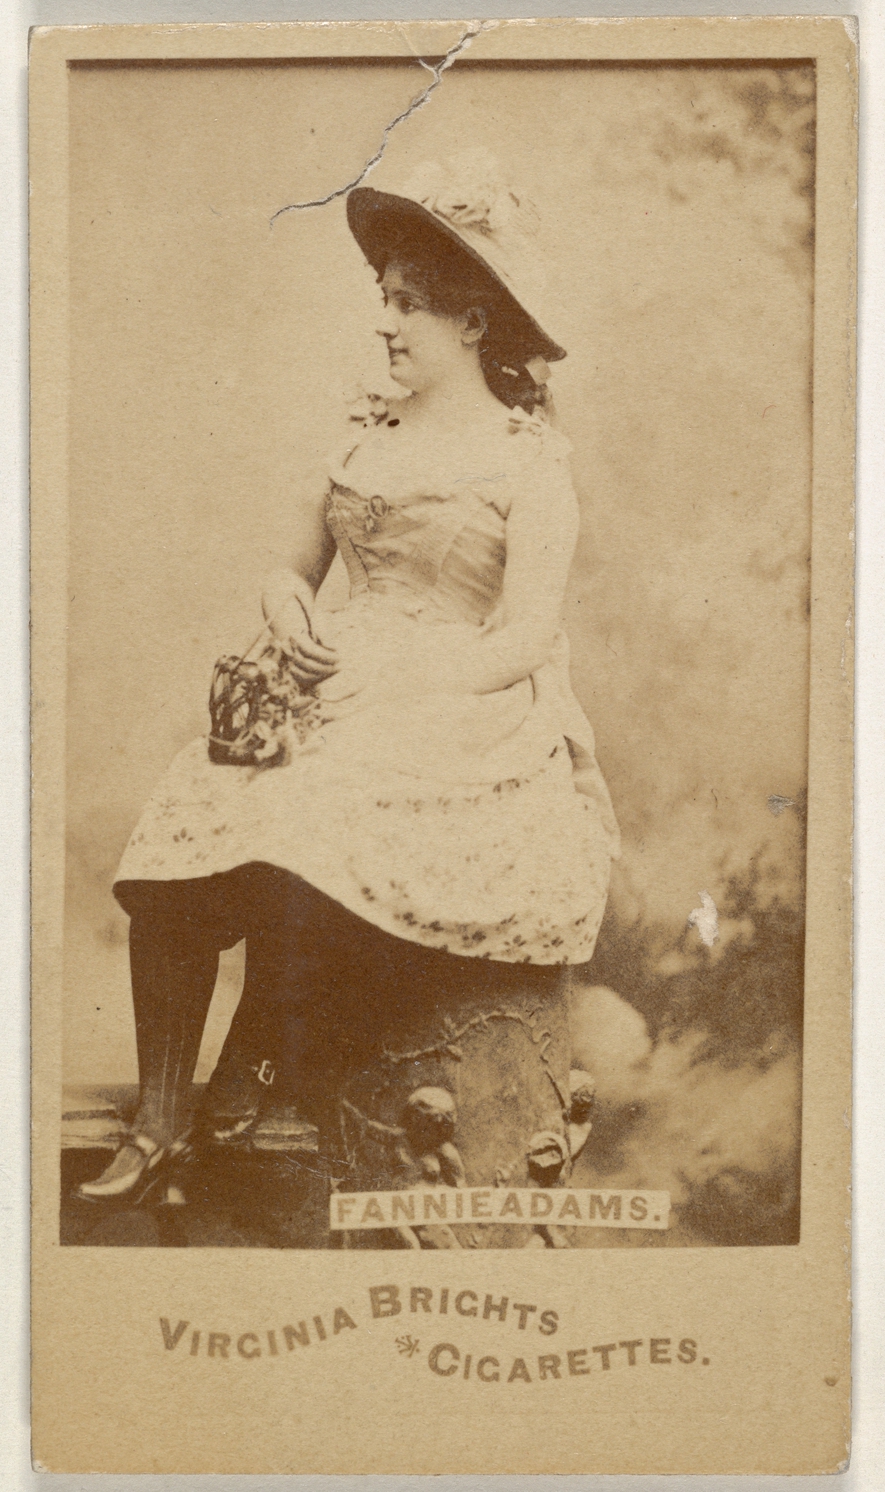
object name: photograph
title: Fannie Adams, from the Actors and Actresses series (N45, Type 6) for Virginia Brights Cigarettes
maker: allen & ginter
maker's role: publisher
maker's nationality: american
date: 1888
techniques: albumen silver print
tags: portraits,women,actresses